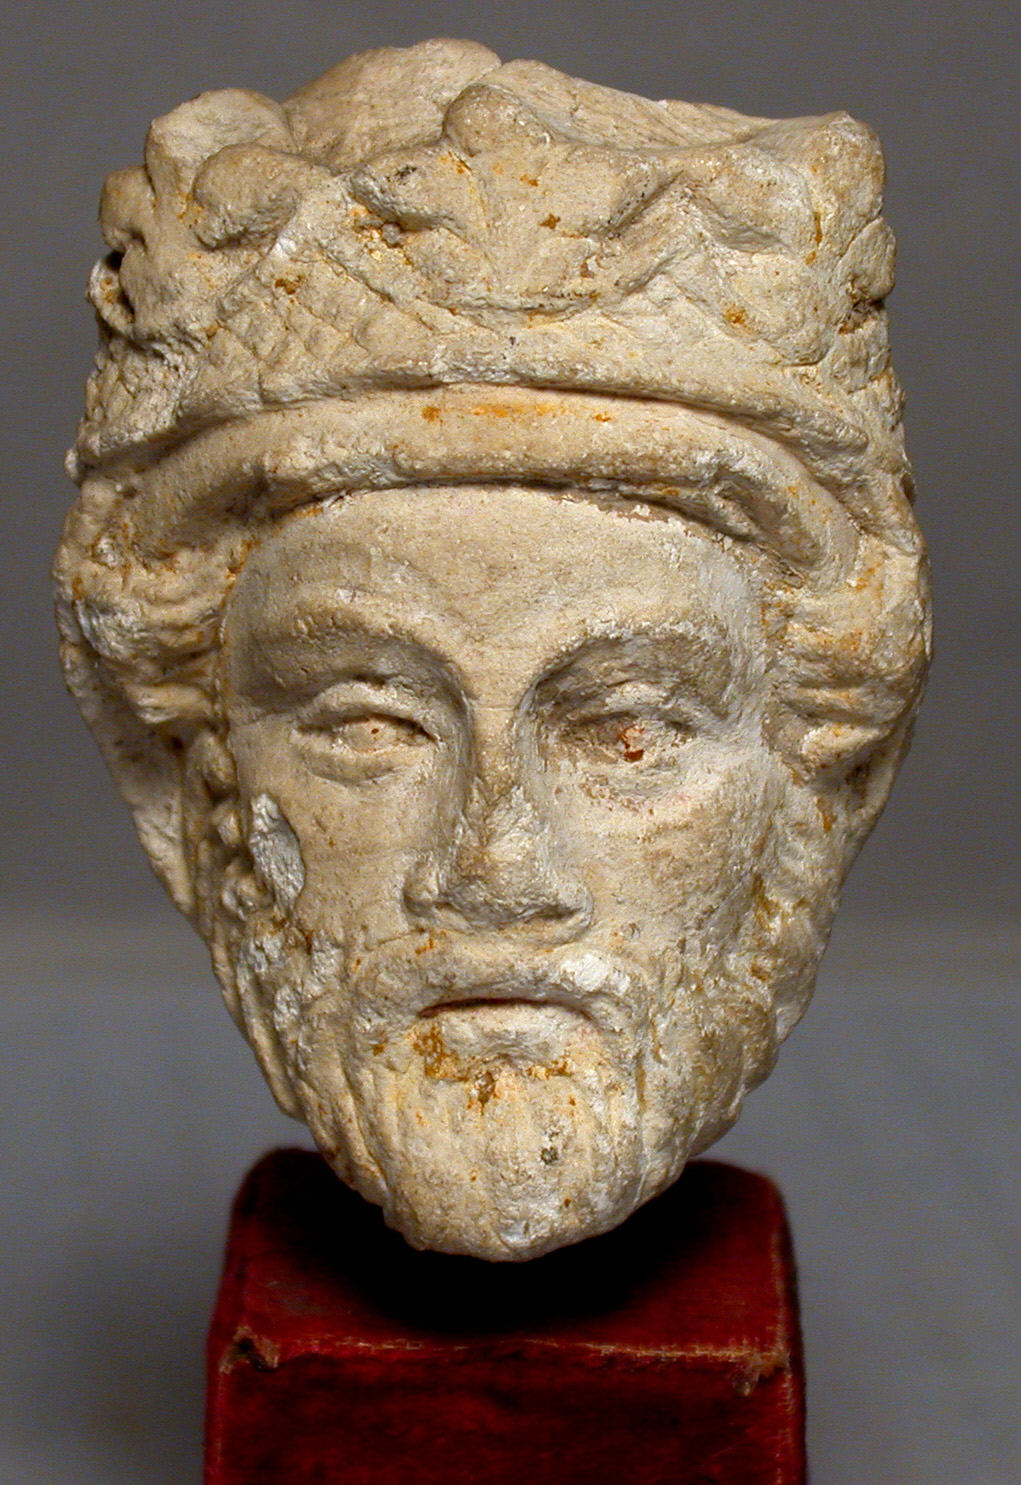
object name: sculpture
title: Head of a Bearded King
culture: french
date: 1301-1400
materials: marble, paint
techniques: gilding